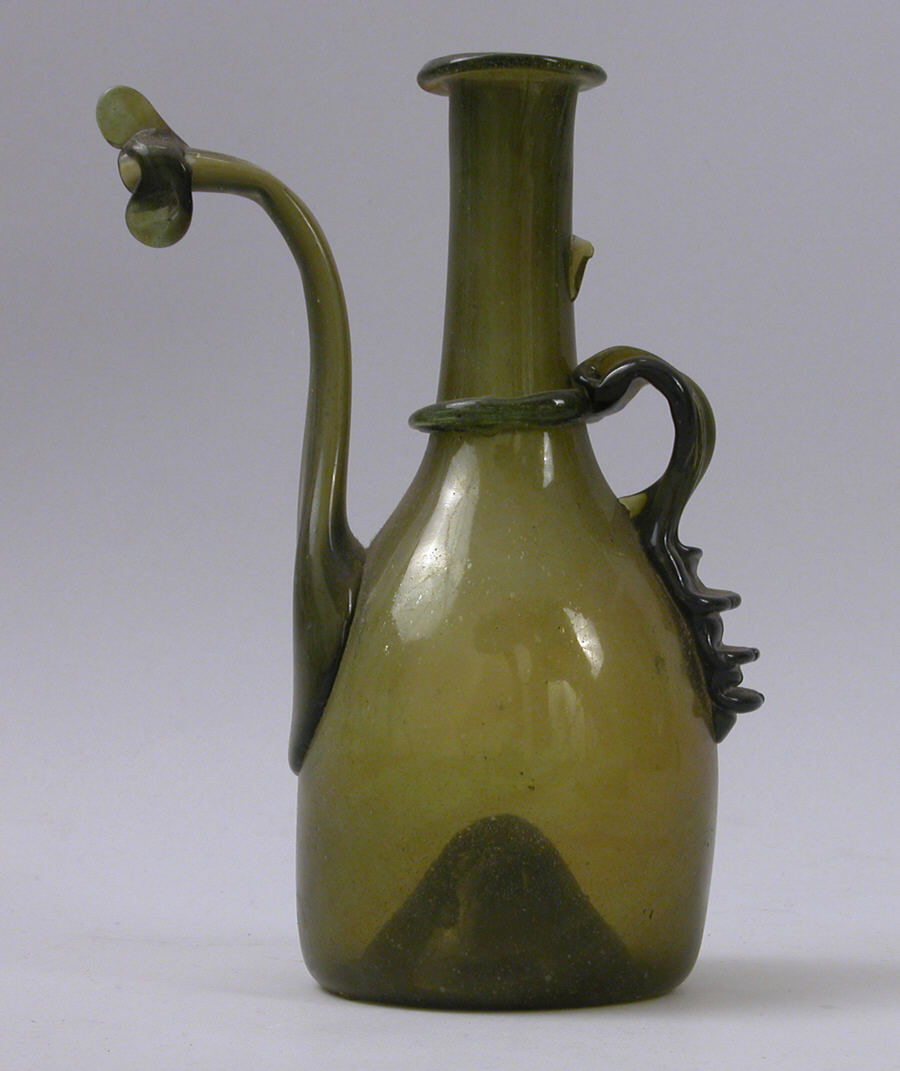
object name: ewer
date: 1701-1900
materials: glass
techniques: glassblowing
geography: iran